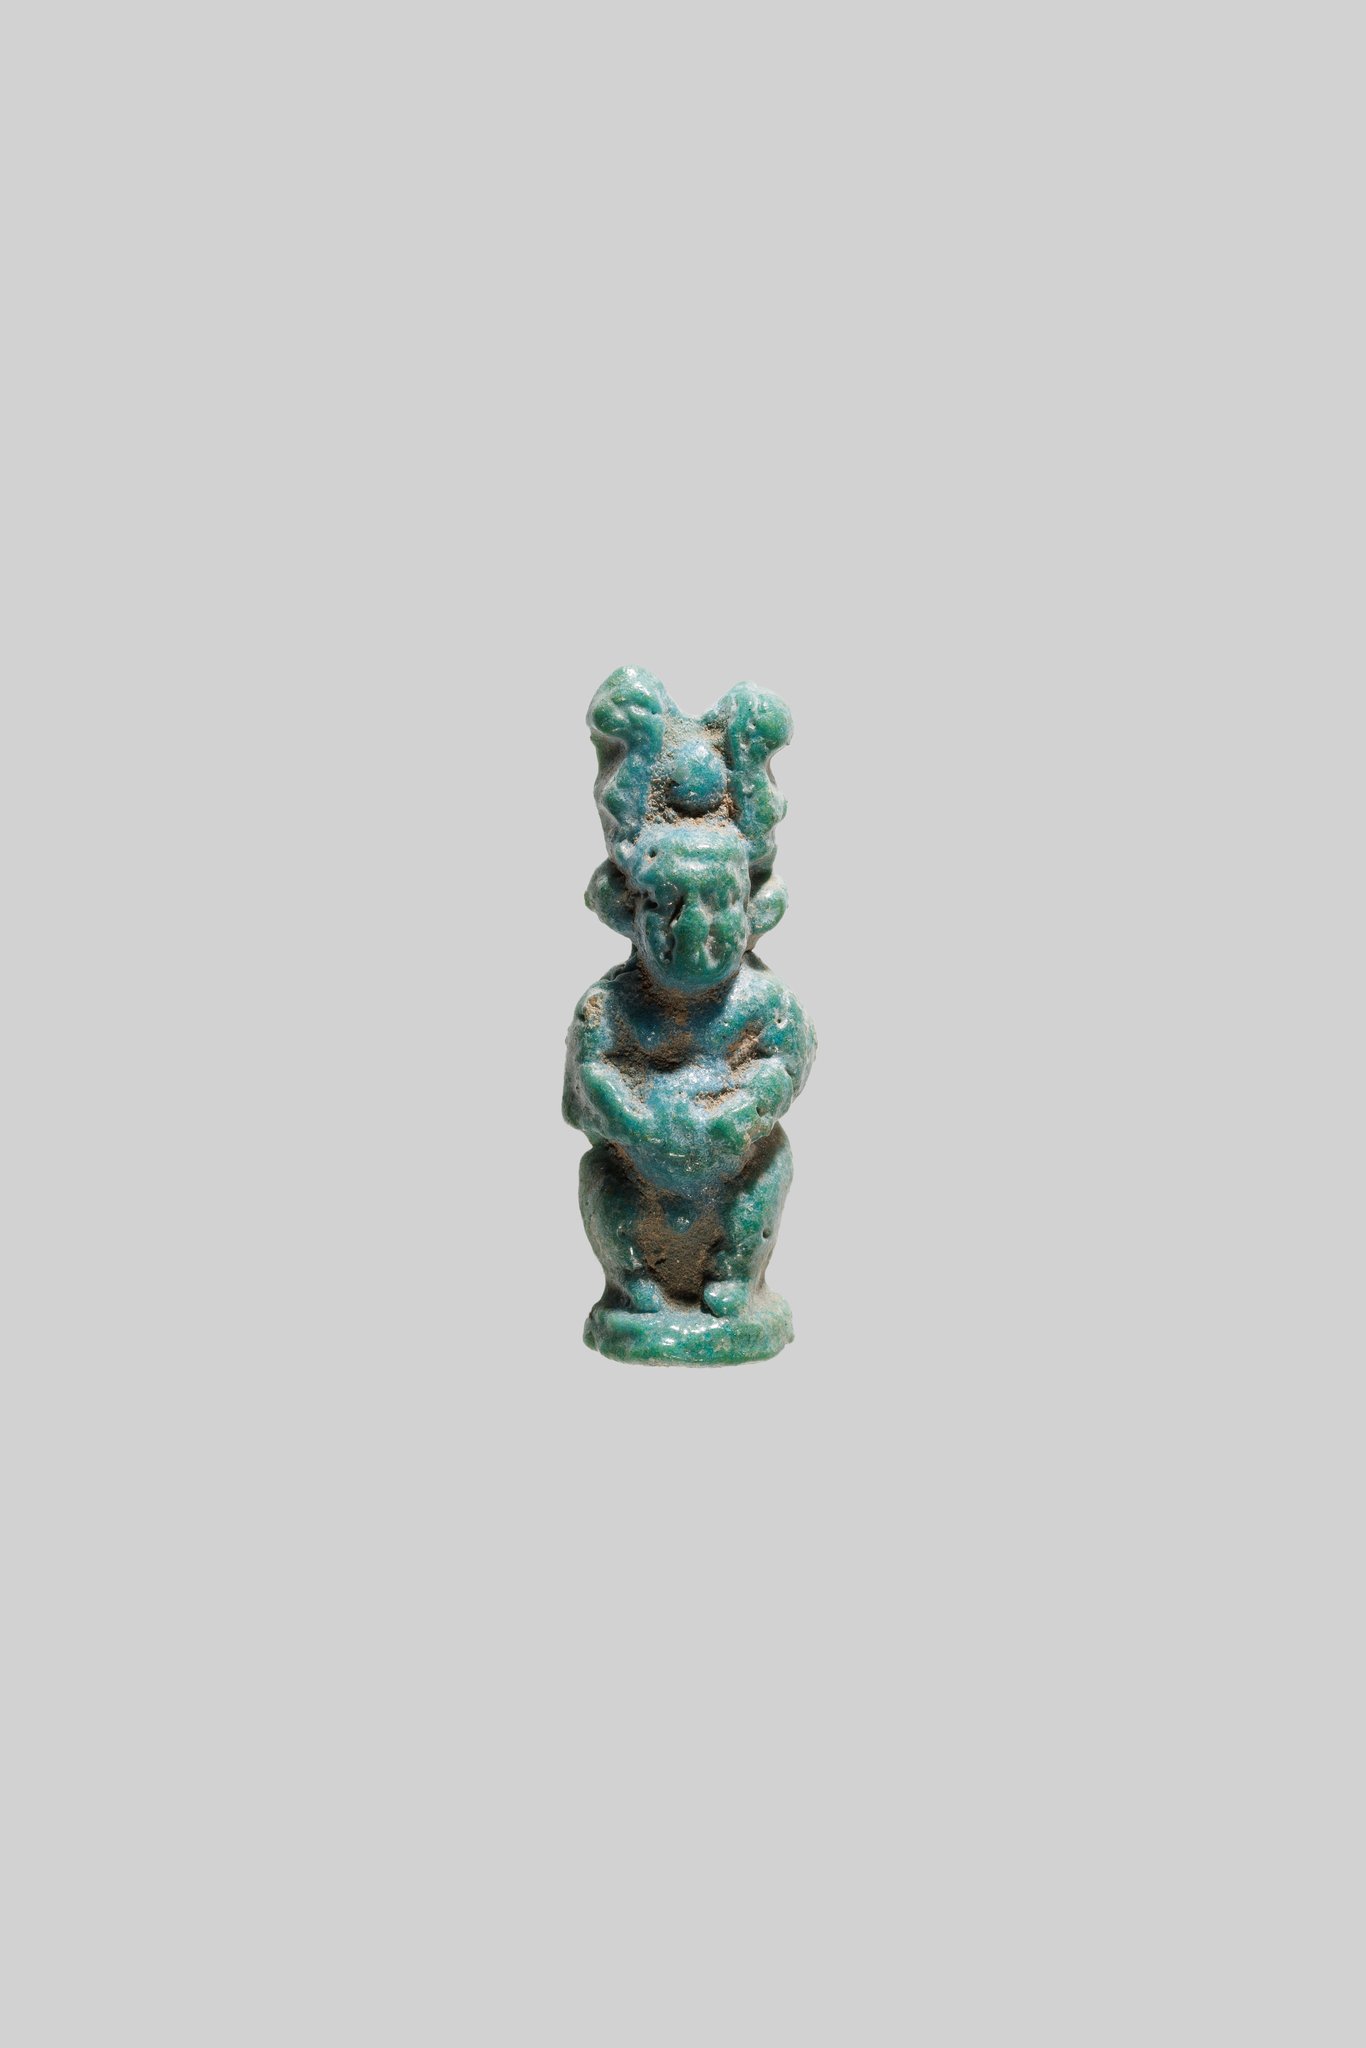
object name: amulet, pataikos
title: Pataikos Amulet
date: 1295-1070 BCE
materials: faience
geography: egypt